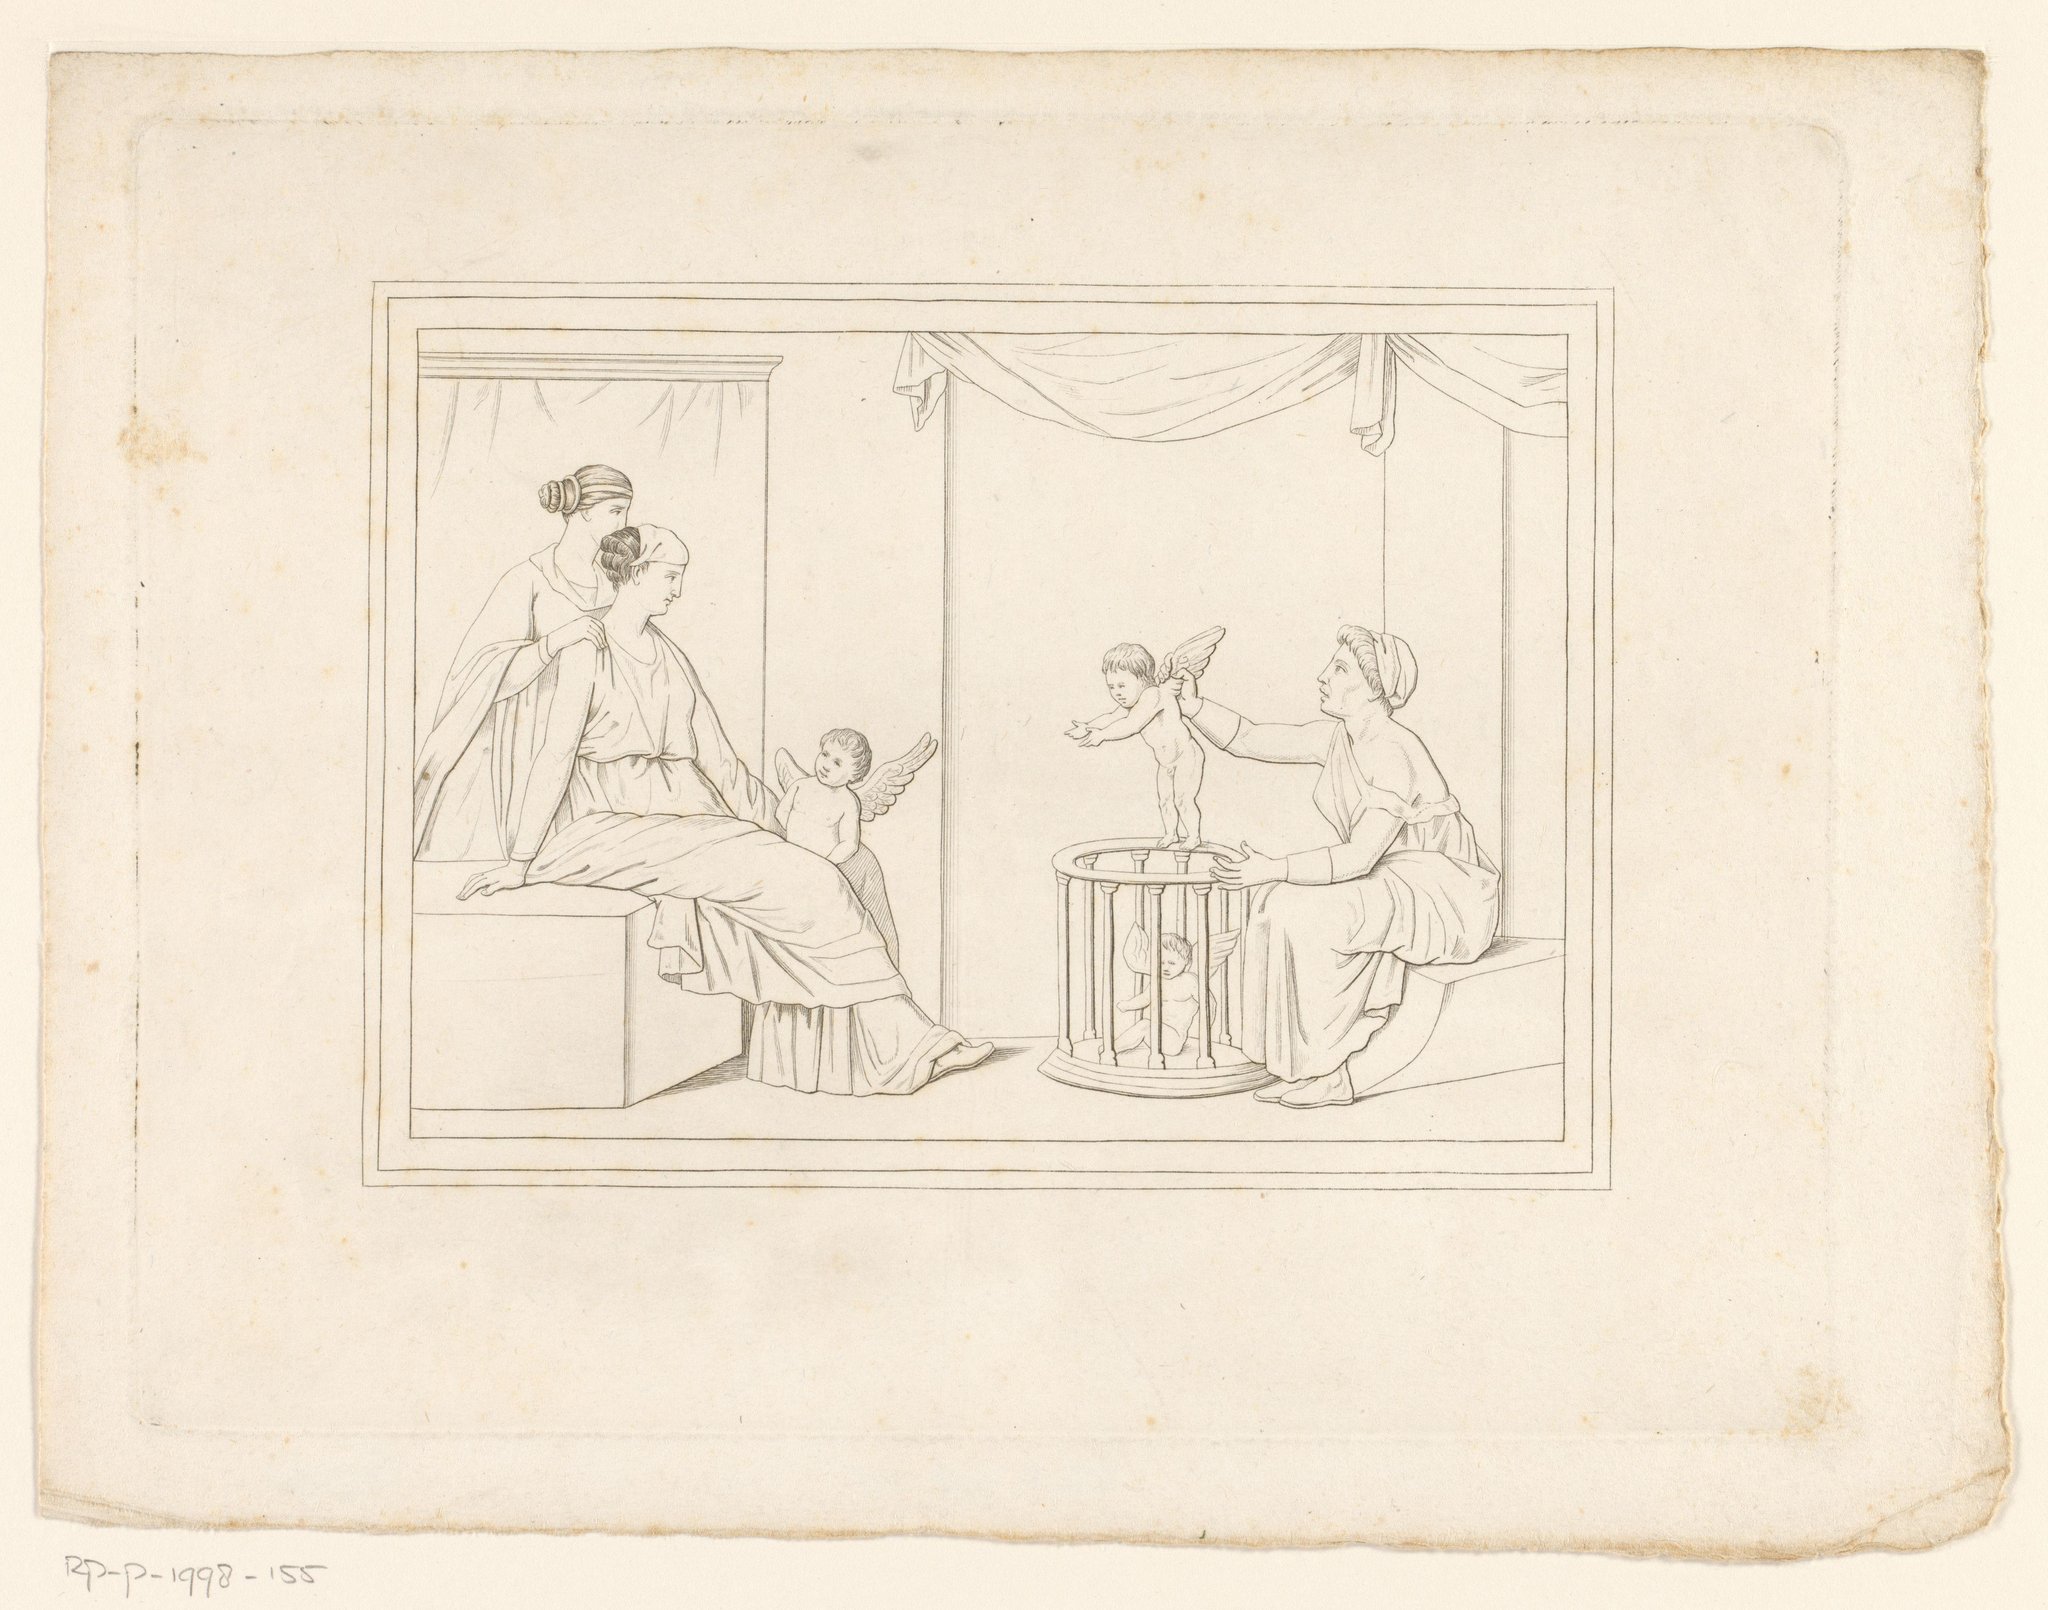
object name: print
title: Objecten van Museum van Oudheden te Napels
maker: Anonymous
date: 1800-1899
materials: paper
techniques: engraving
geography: italy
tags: adult woman, cupids: 'amores', 'amoretti', 'putti'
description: Reproductie van een fresco in Pompejaanse stijl. Links zitten twee vrouwen bij een putto. Rechts haalt een dienstmaagd putti uit een ronde box.